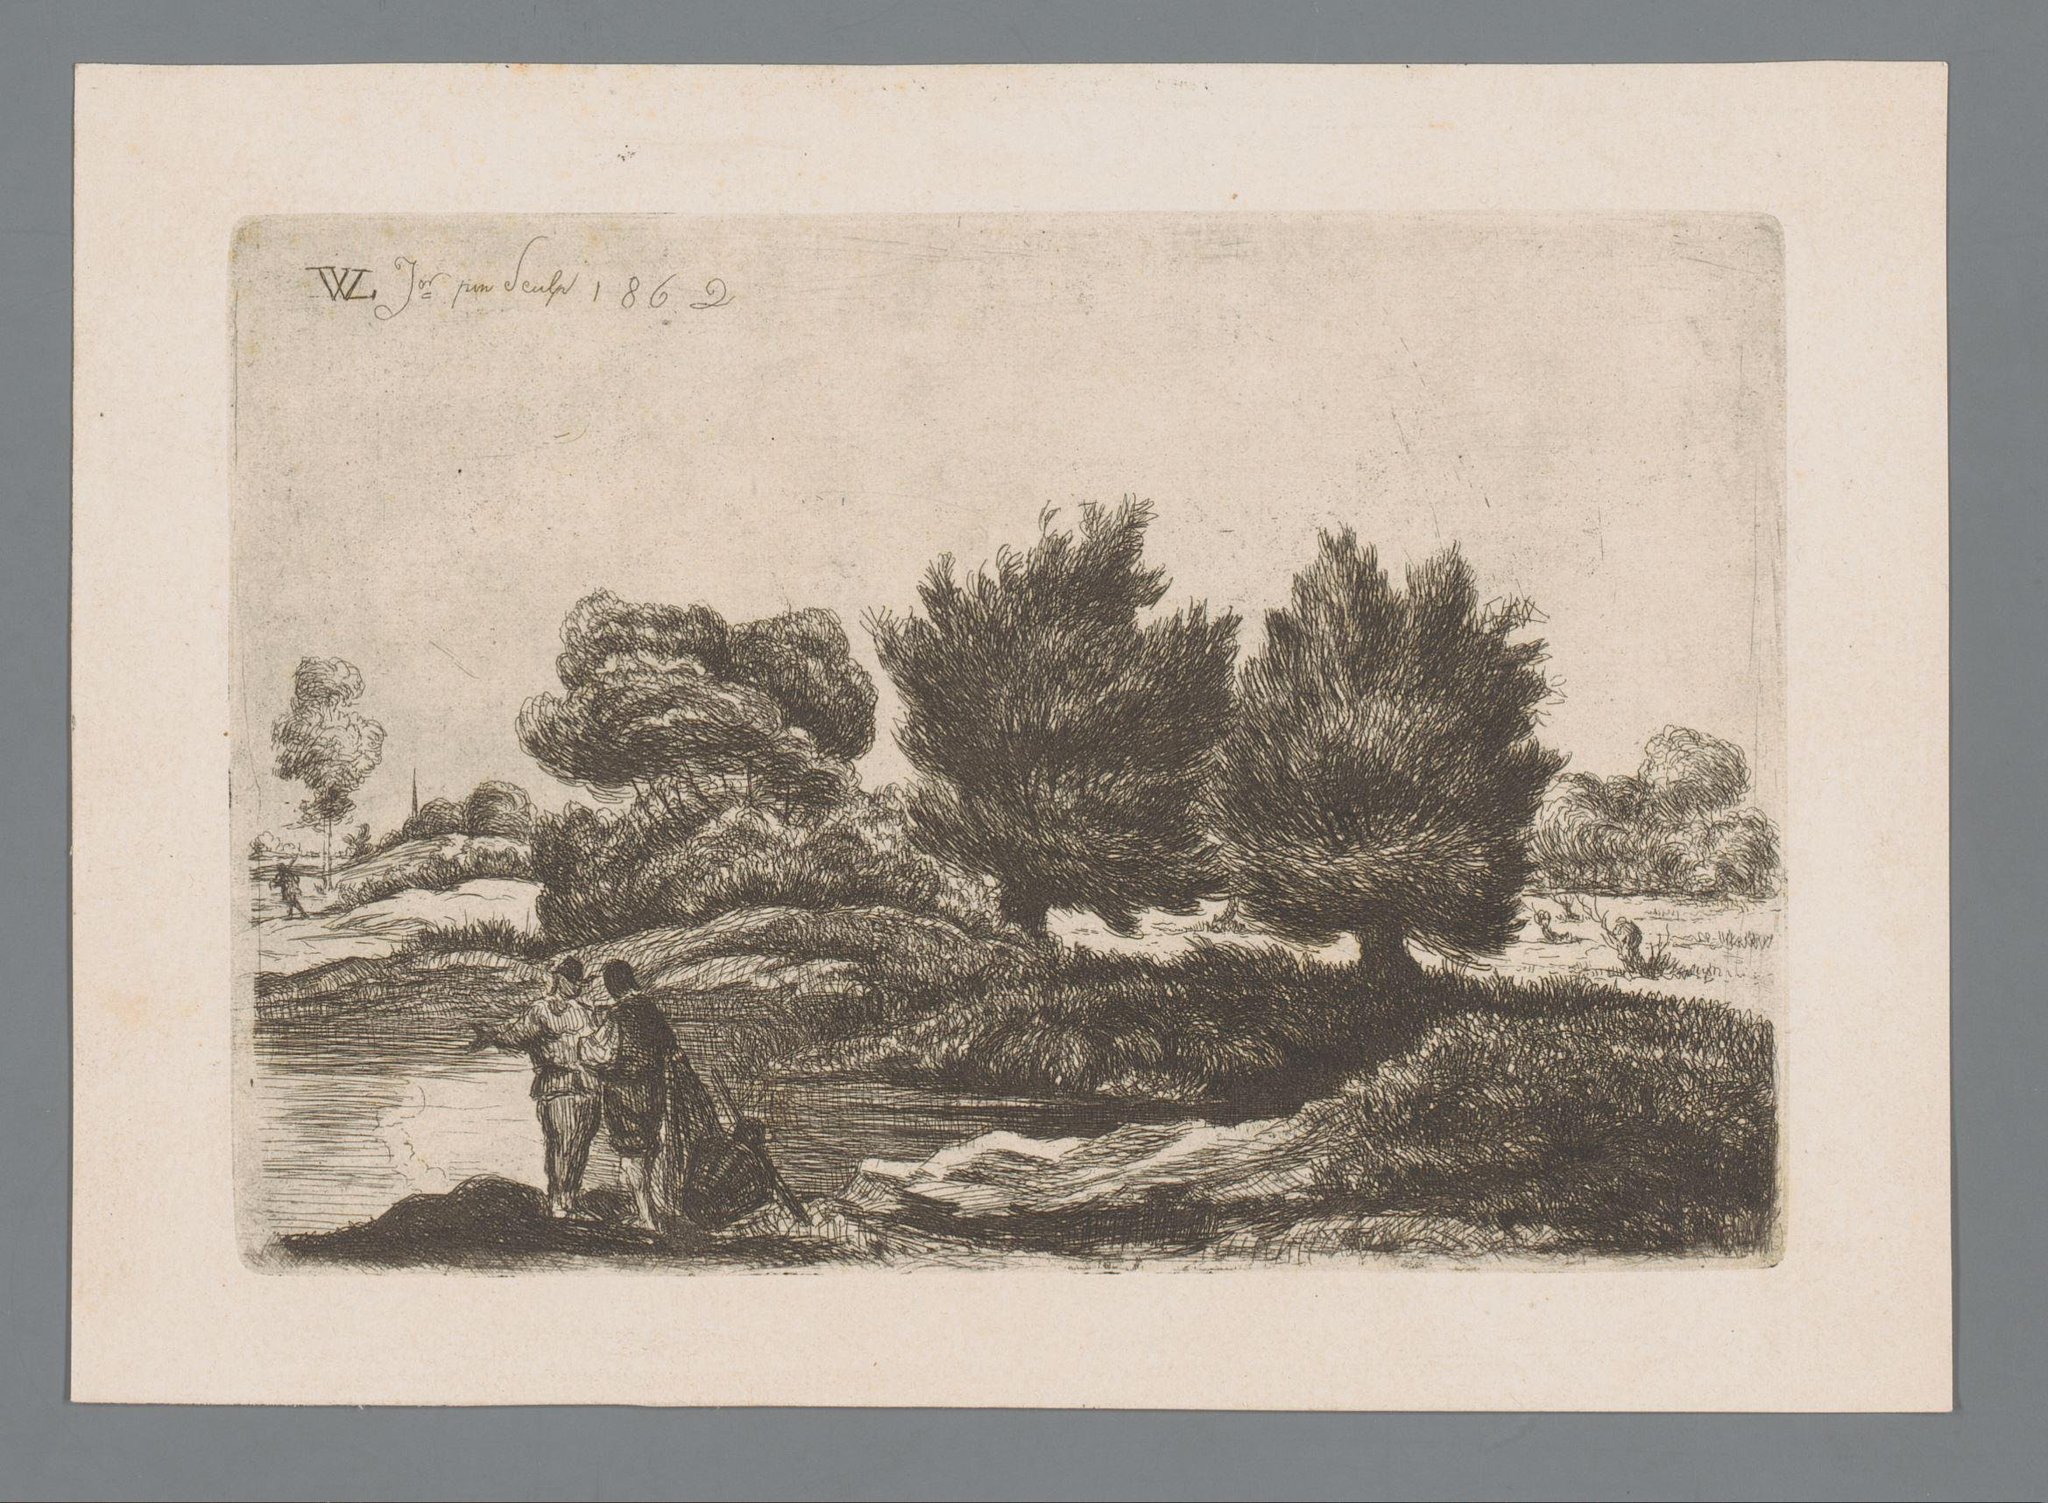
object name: print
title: Figuren in een landschap met wilgen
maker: willem linnig (ii)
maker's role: print maker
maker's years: 1842-1890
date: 1862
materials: paper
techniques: etching, intaglio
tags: trees: willow, landscapes in the temperate zone (+ landscape with figures, staffage)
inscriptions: collector's mark: Lugt 1485, collector's mark: Lugt 2228